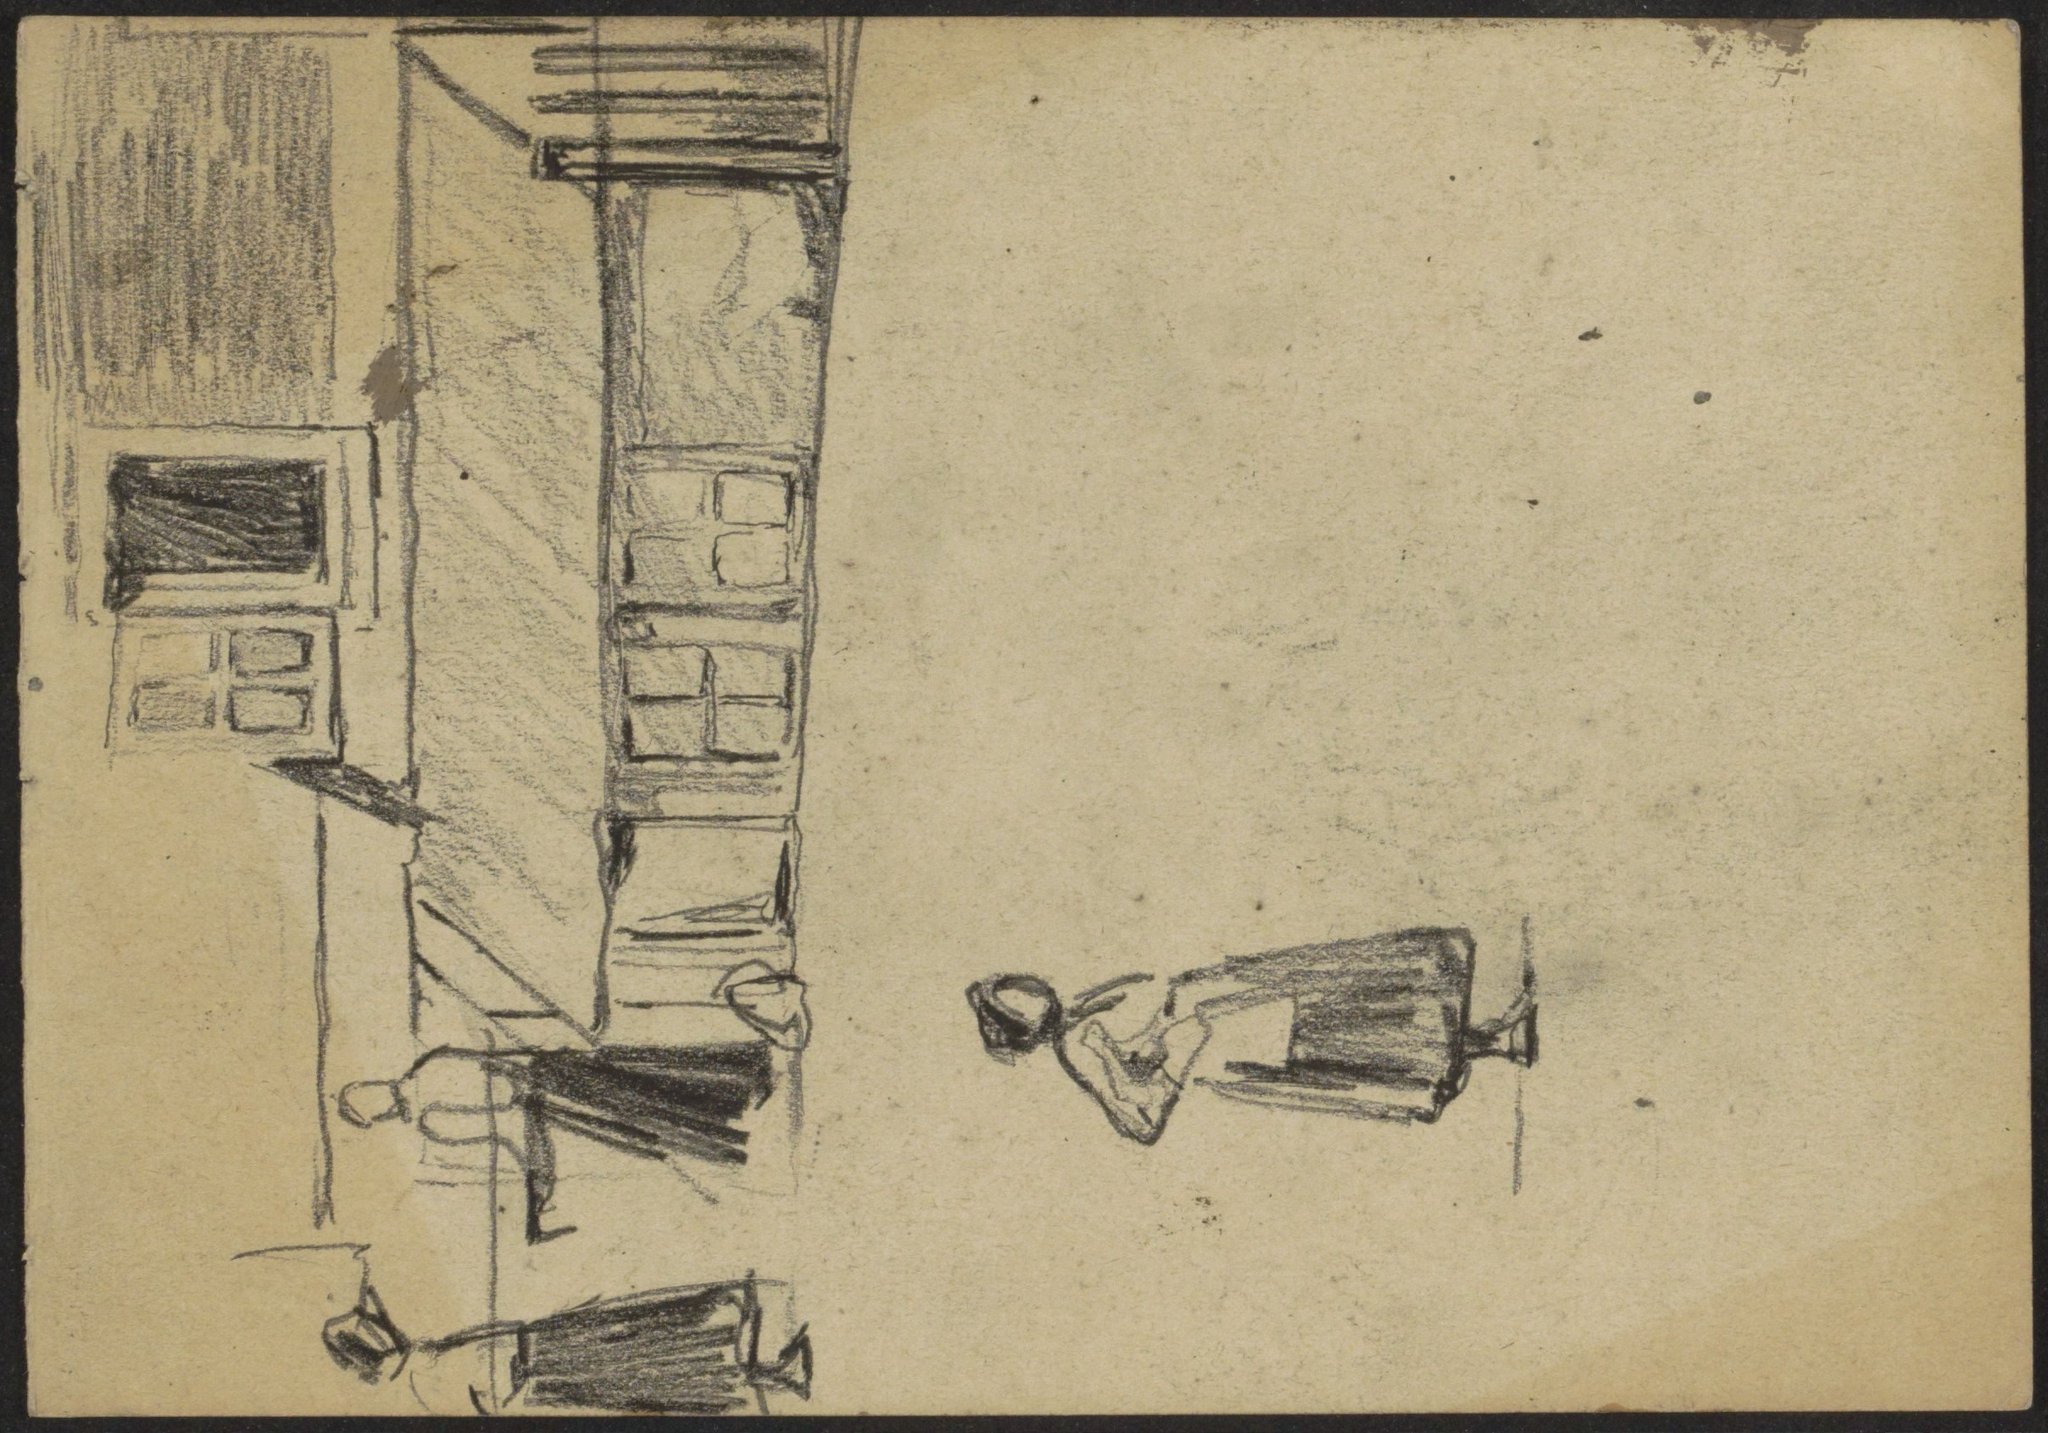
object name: sketchbook leaf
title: Figuren voor de zijgevel van het pand Korte Dijkstraat 2 in Amsterdam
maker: willem witsen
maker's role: draughtsman, painter, print maker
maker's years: 1860-1923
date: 1907-1909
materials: paper, pencil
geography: amsterdam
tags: urban housing, street (+ city(-scape) with figures, staffage)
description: Witsen begon met het vervaardigen van de prenten in september 1907.